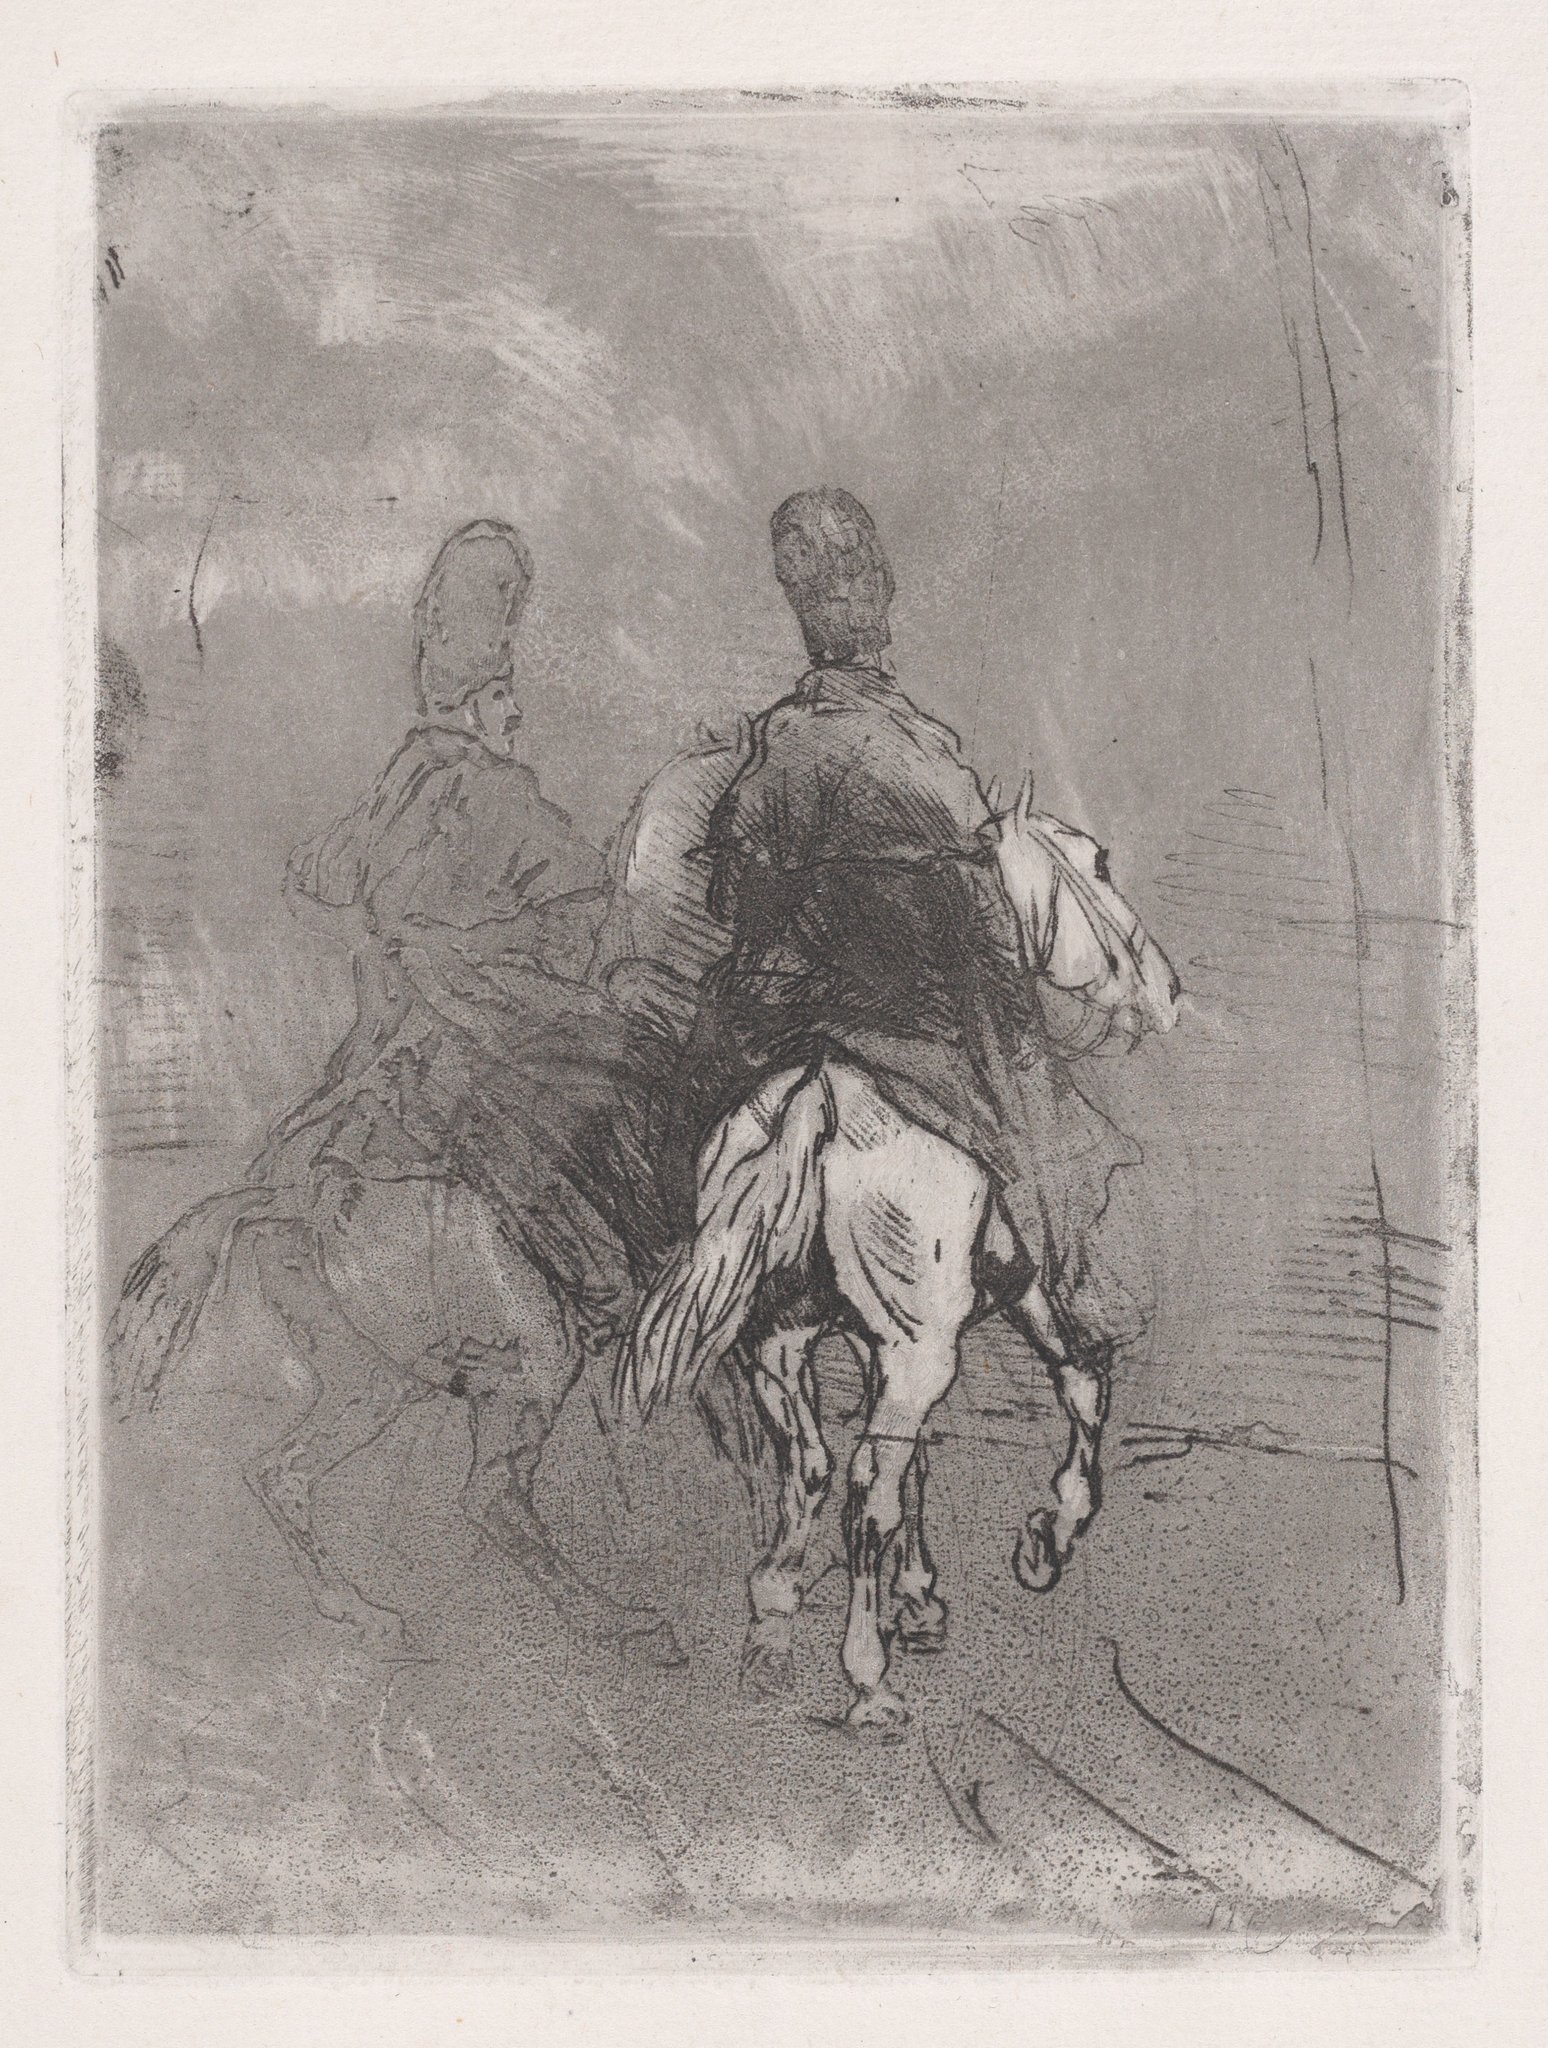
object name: print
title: Mounted Cossacks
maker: john-lewis brown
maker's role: artist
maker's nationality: french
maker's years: 1829-1890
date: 1801-1900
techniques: aquatint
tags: men,horses